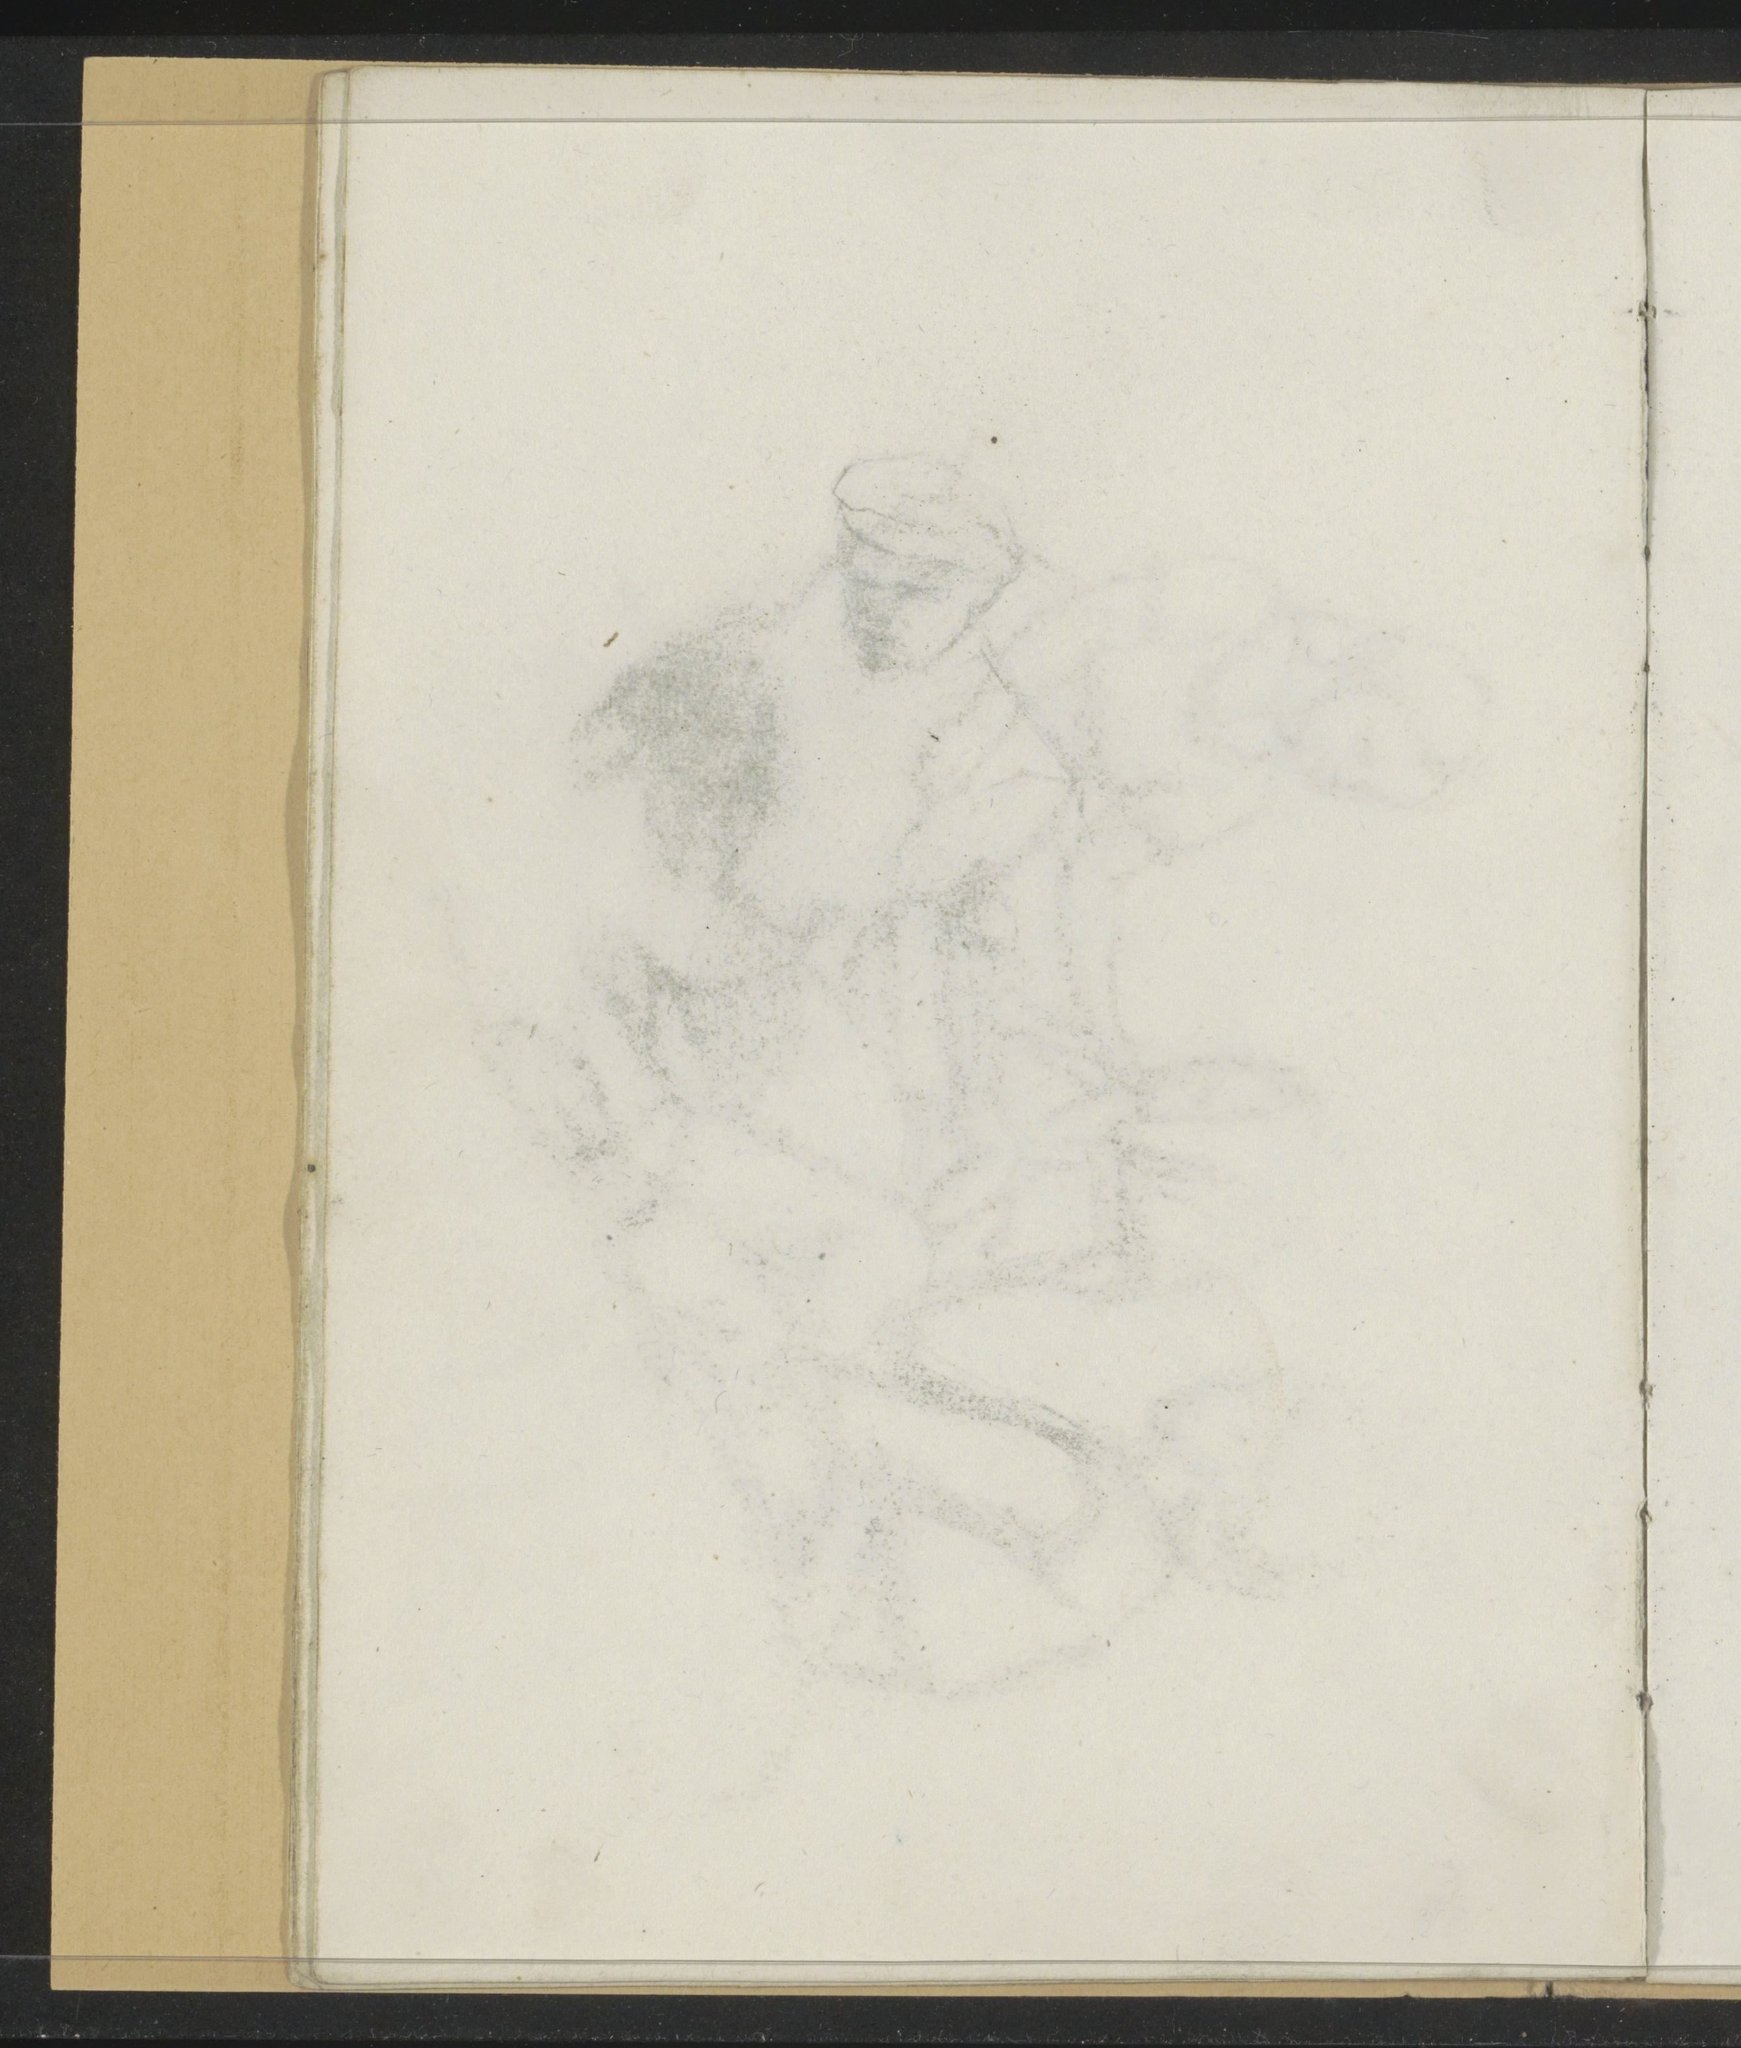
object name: sketchbook leaf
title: Kop van een man met een pet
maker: jozef israëls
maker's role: draughtsman, painter, print maker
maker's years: 1824-1911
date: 1834-1911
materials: paper, pencil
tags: head (human) (+ male human being (not to be used where -a- is prescribed)), head-gear: hat (+ men's clothes)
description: Blad 6 verso uit een schetsboek met 16 bladen.